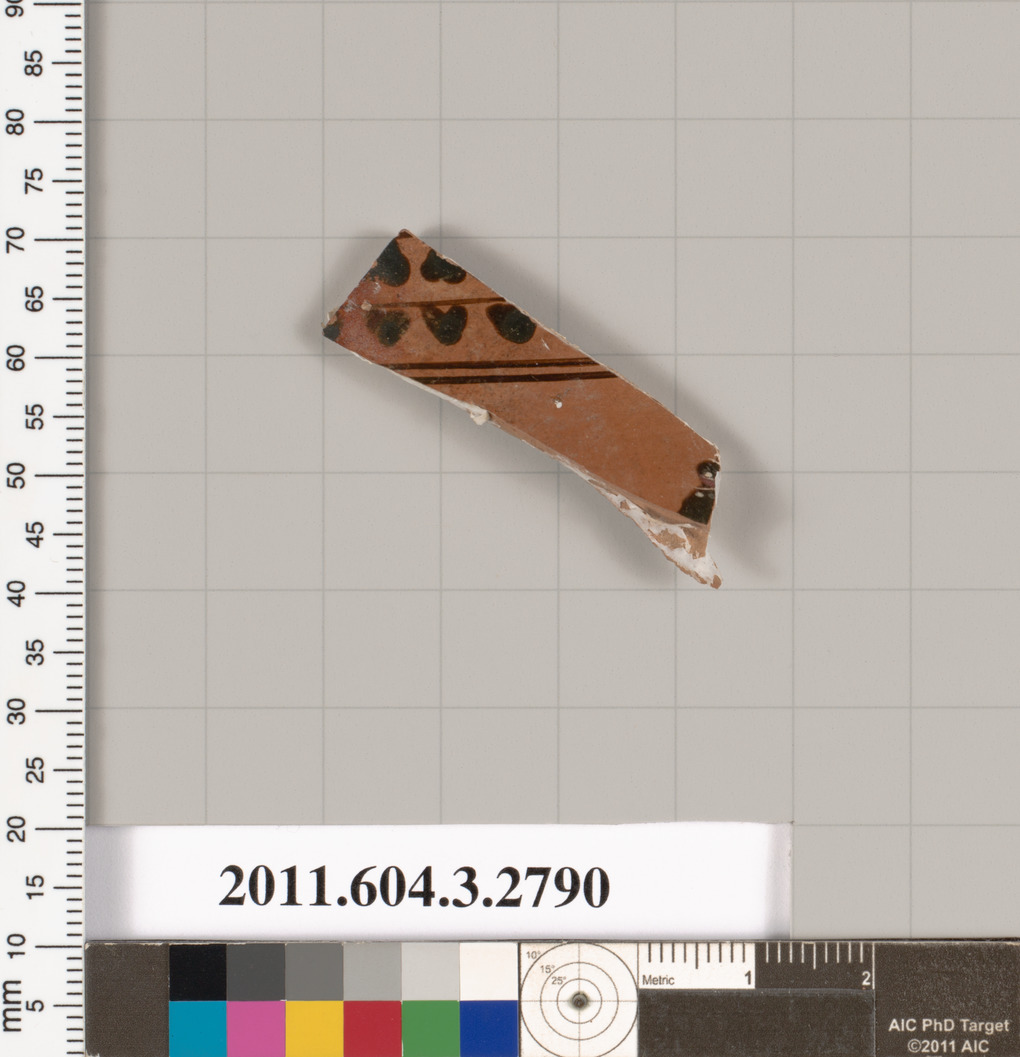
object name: olpe fragment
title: Terracotta fragment of an olpe (jug)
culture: greek, attic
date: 525-501 BCE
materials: terracotta